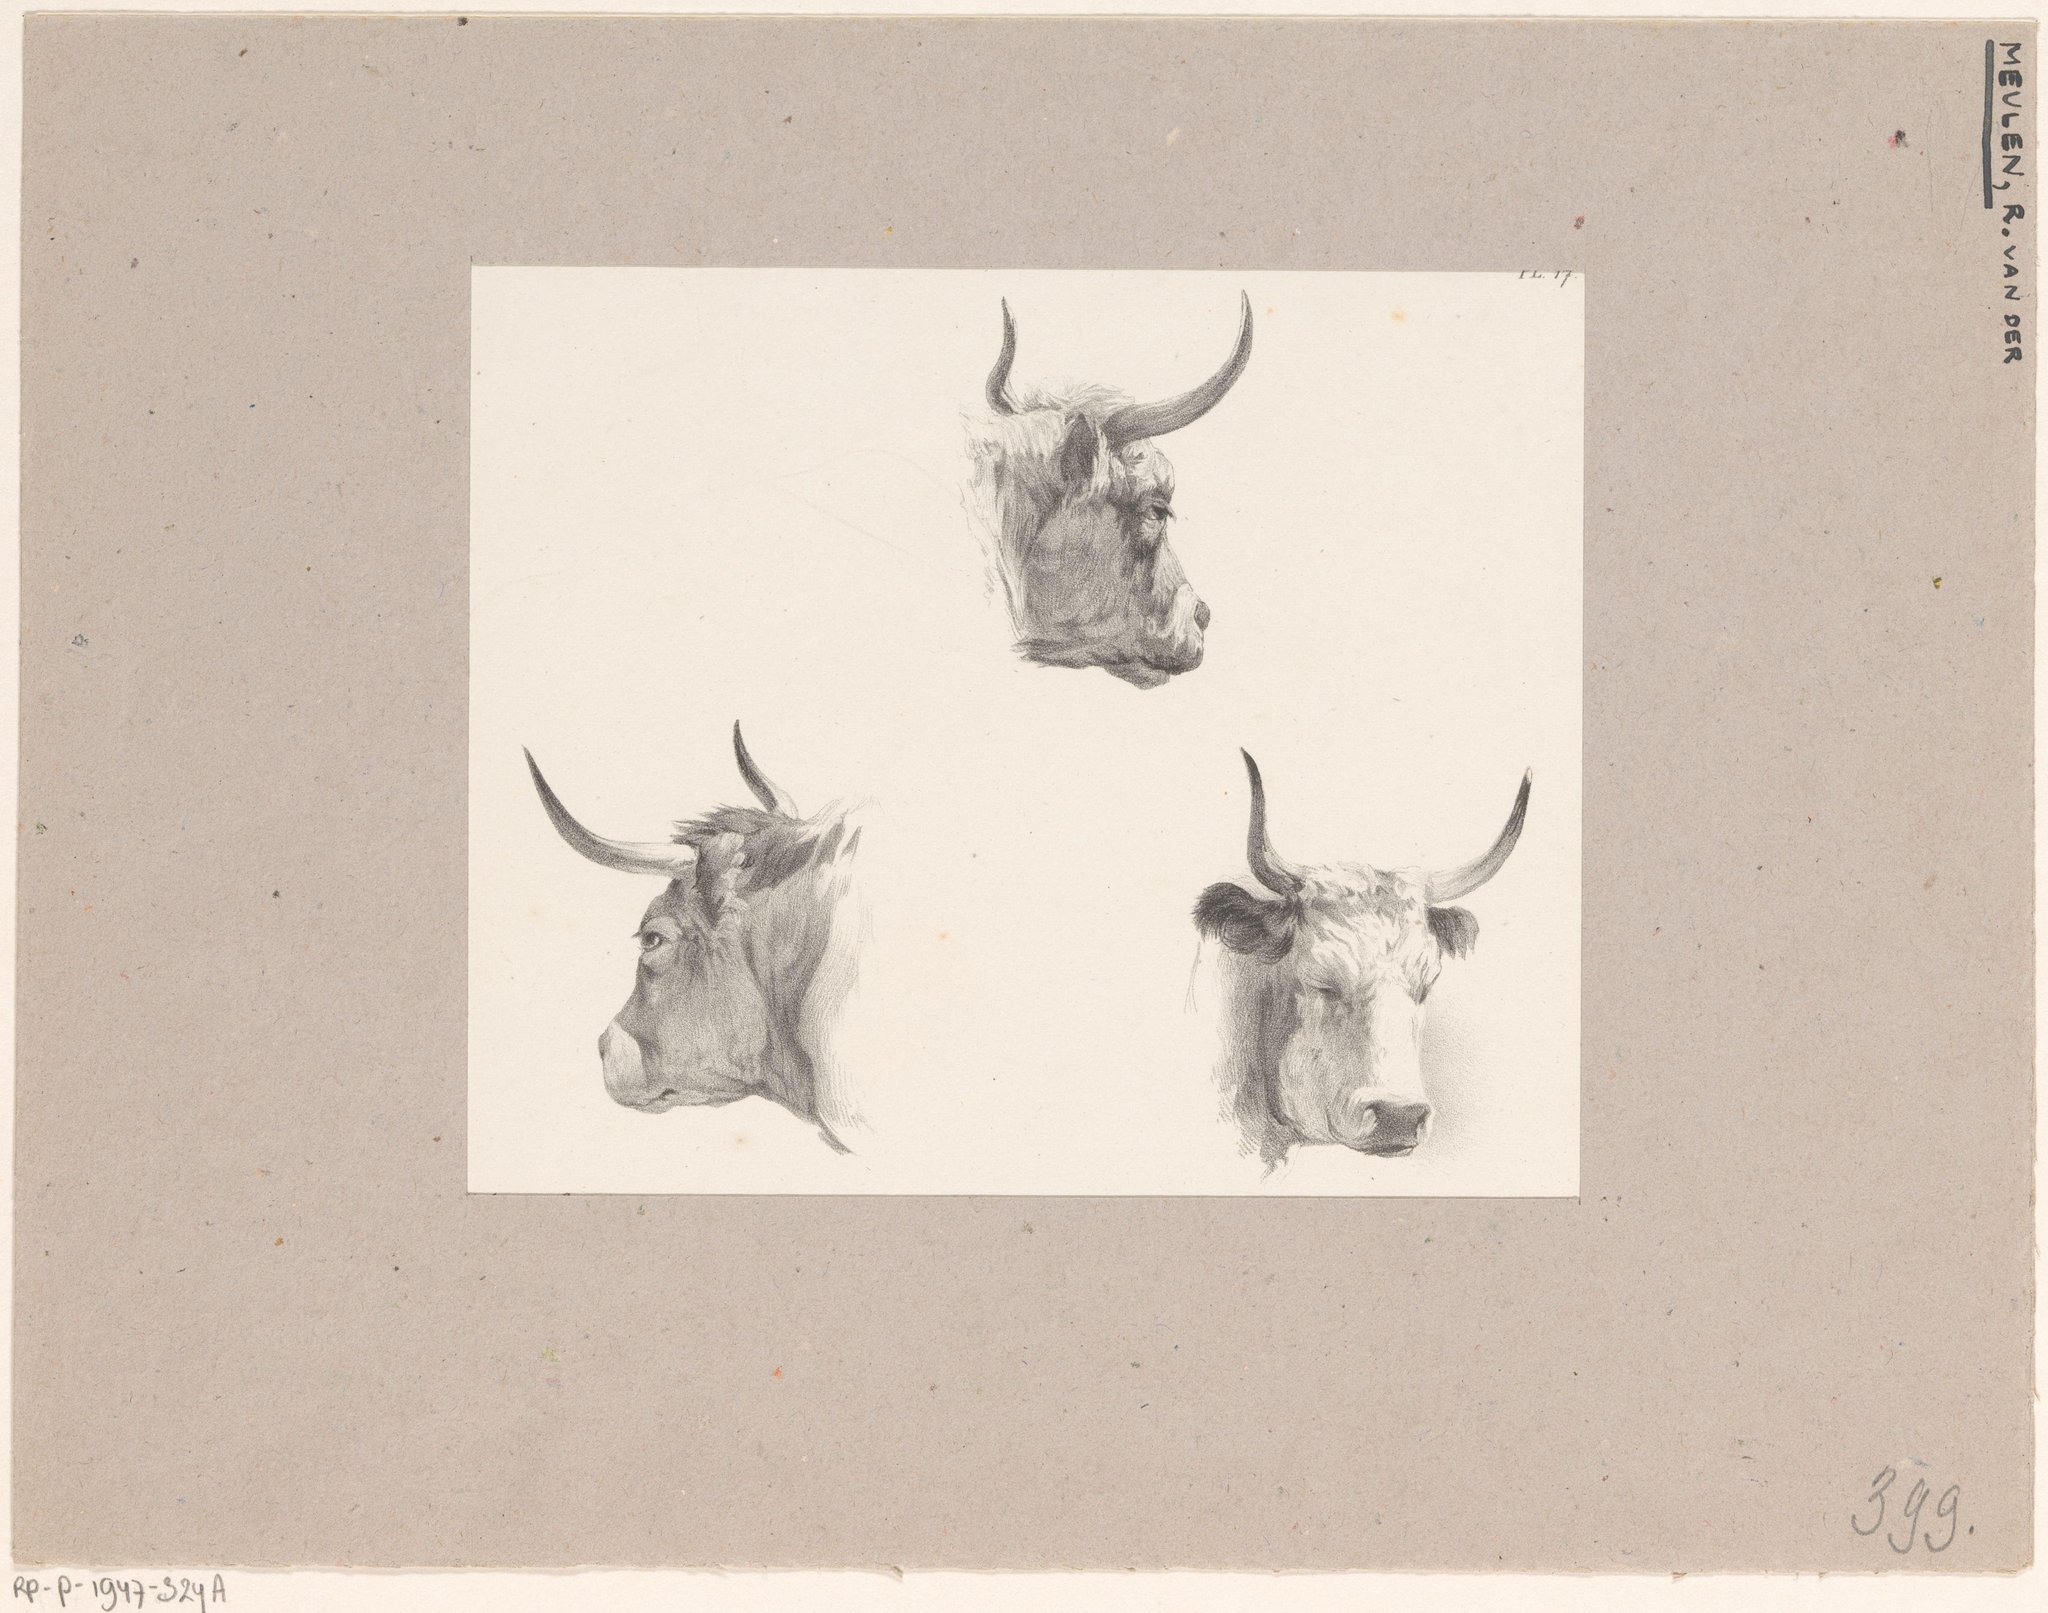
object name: print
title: Drie ossekoppen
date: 1820-1833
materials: paper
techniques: lithograph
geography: amsterdam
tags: ox (+ head of an animal)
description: Deze prent maakte mogelijk deel uit van de serie: 'Origineele Beesten Studien op Steen getekend na Potter, Van de Velde, Berghem, en andere Oude Hollandsche Meesters' door J. A. Daiwaille.